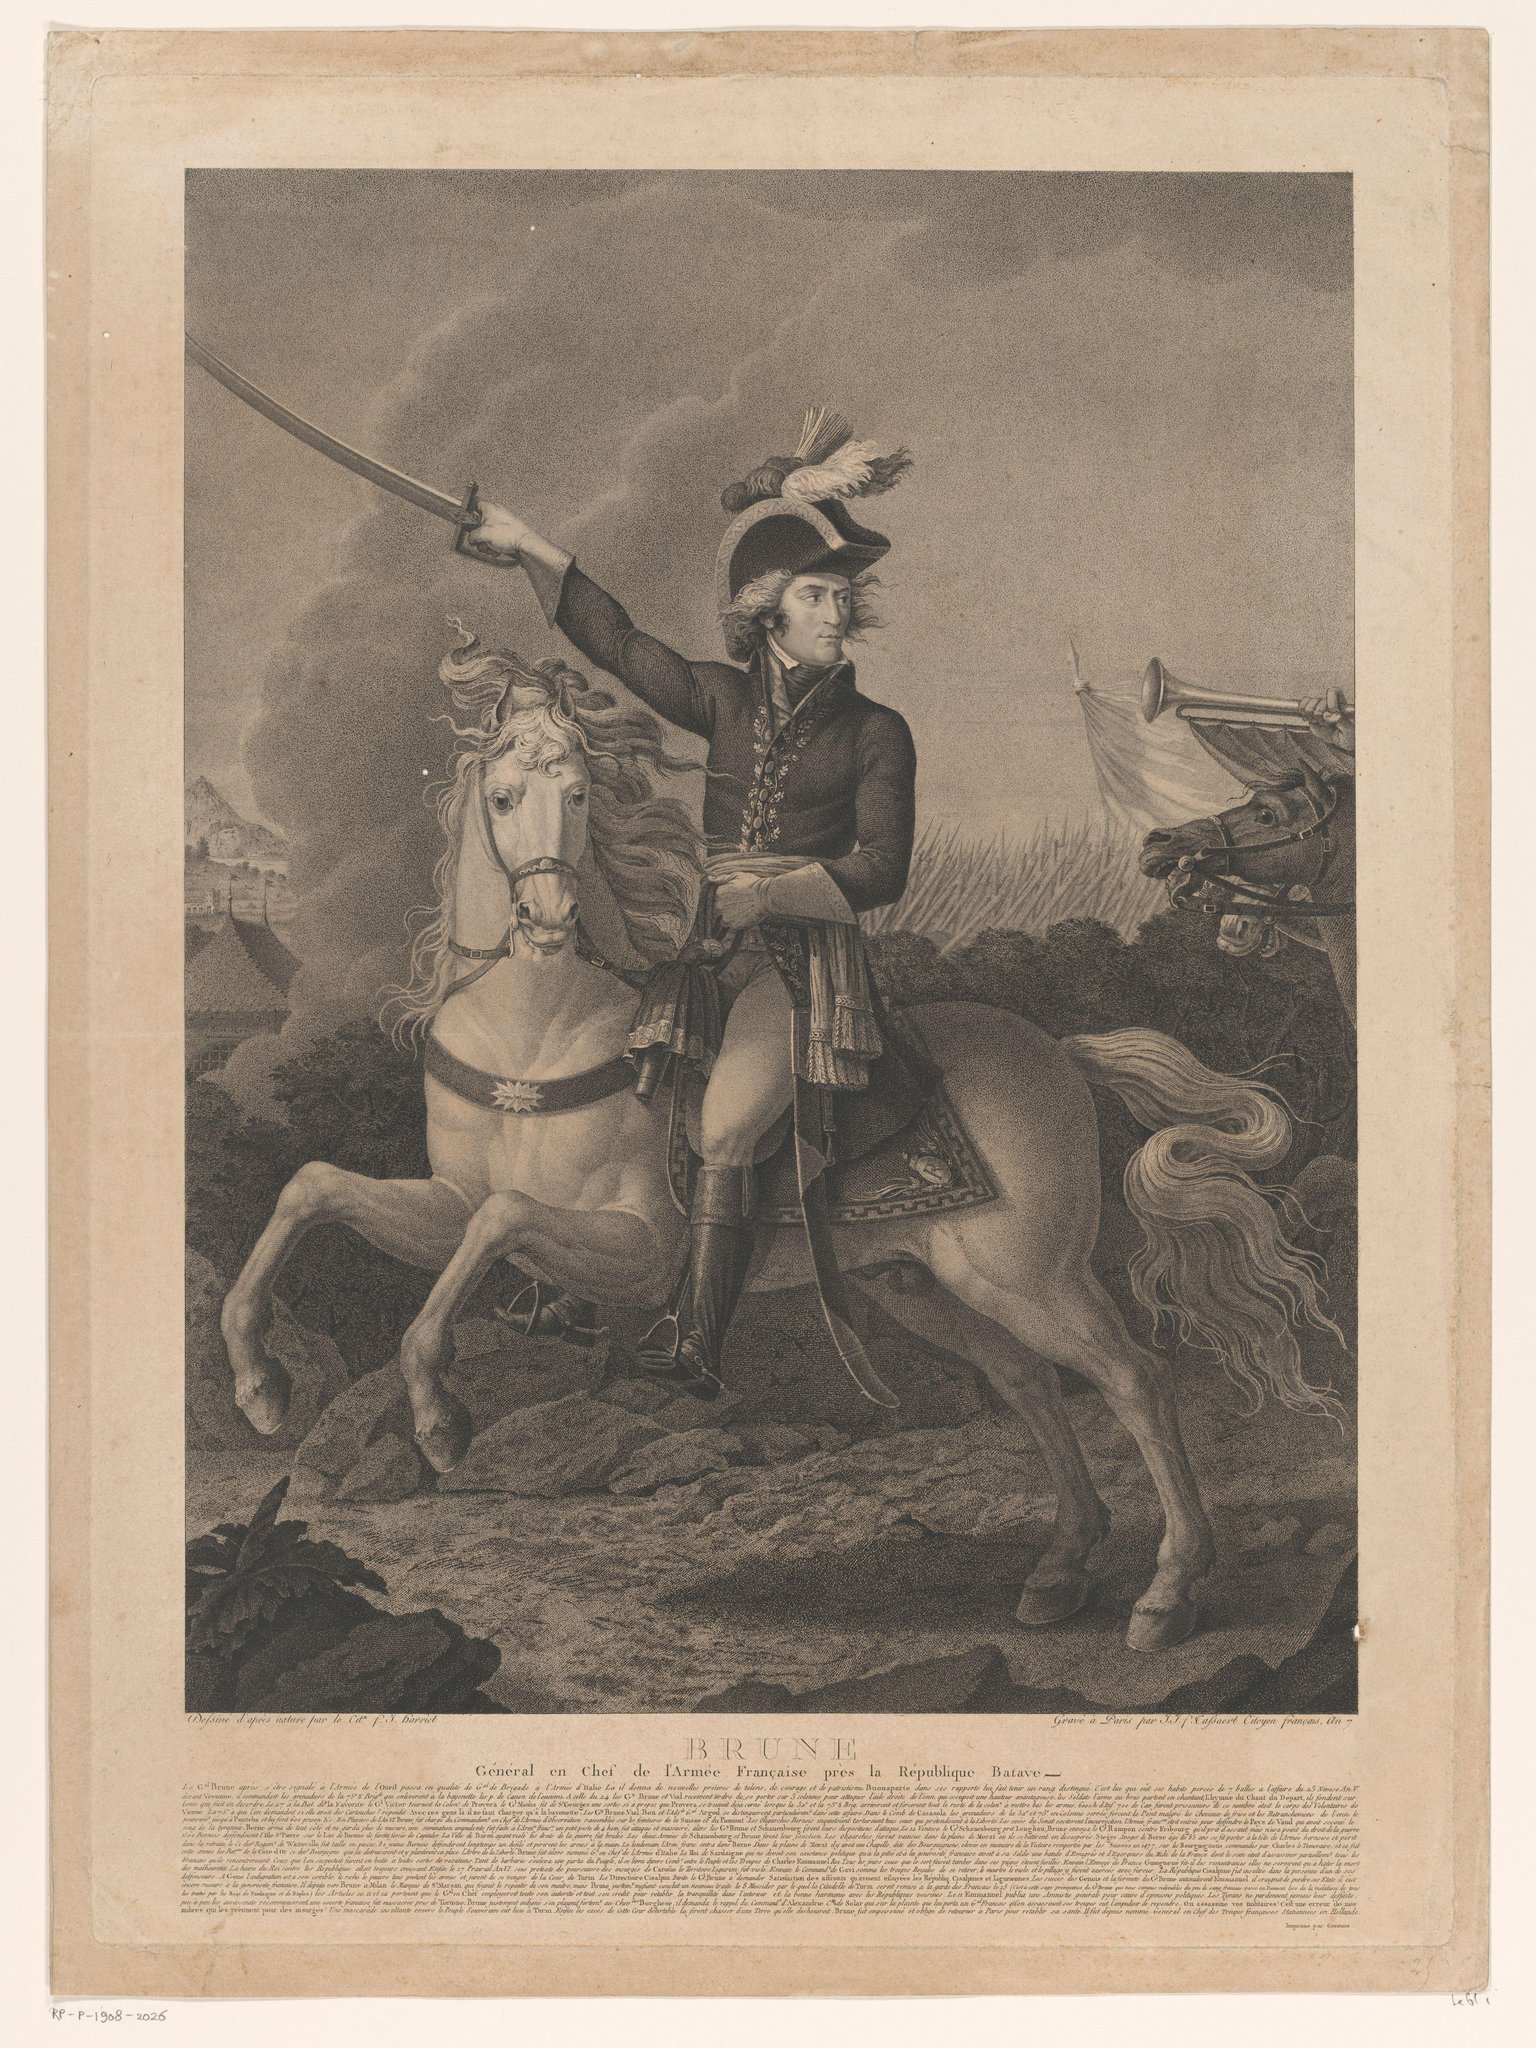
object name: print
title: Portret van generaal Guillaume-Marie-Anne Brune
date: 1807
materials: paper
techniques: etching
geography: paris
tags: historical persons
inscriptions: collector's mark: Lugt 2228